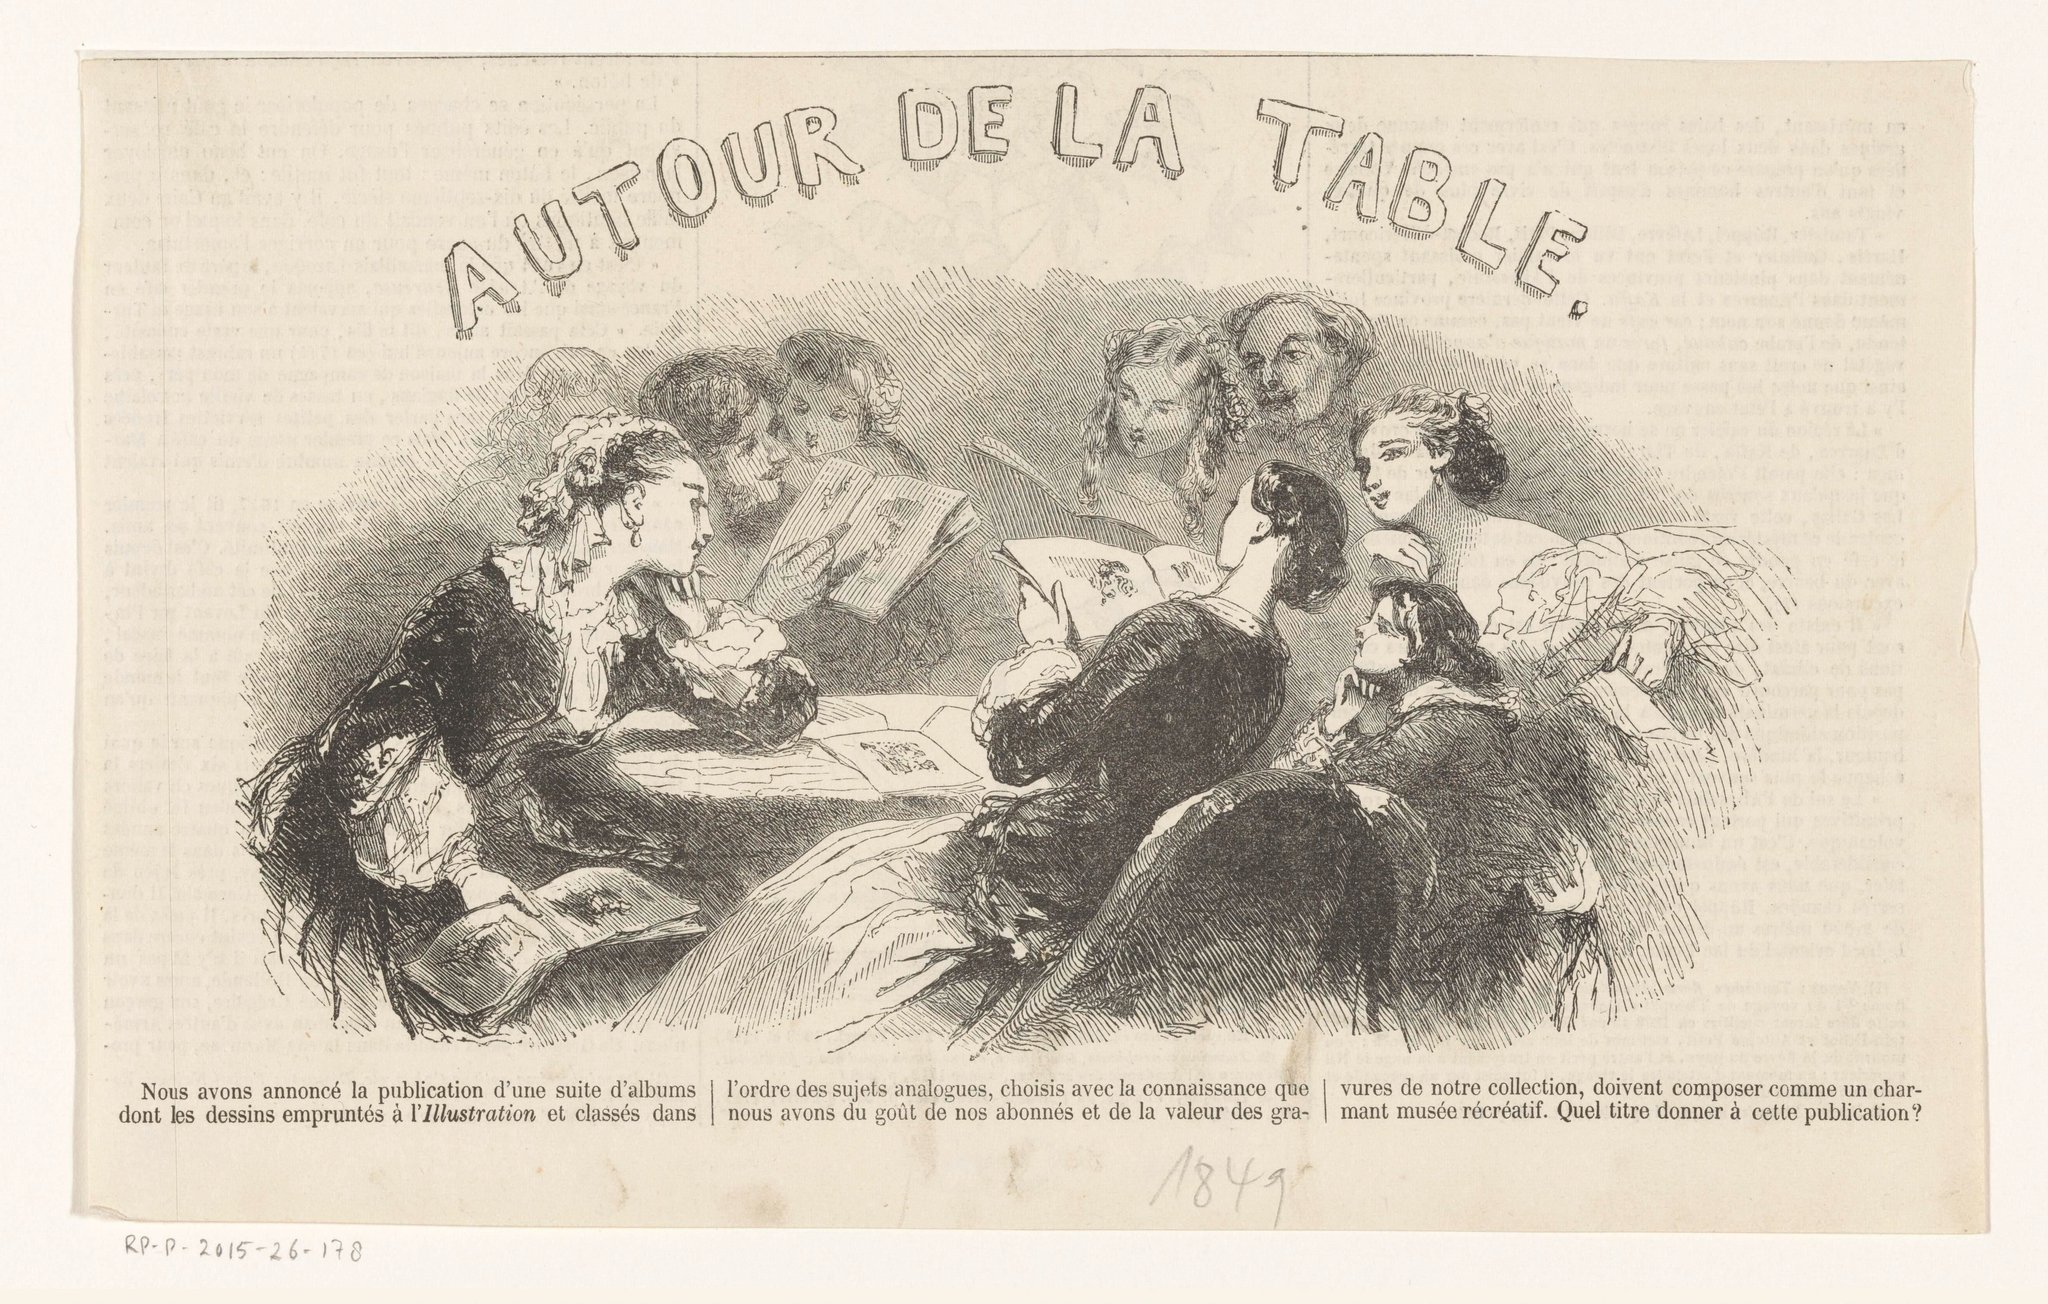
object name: book illustration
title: Autour de la table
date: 1849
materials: paper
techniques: letterpress printing, engraving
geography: paris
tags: book in which illustrations are essential - mm - book open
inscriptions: collector's mark: Lugt 4779, collector's mark: Lugt 4780, collector's mark: Lugt 2228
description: Prent uit: L'illustration. Dl. 14. Parijs: A. le Chevalier et Cie, 1849, p. 157. De prent is een aankondiging voor een album met prenten van Theodore Maurisset: Autour de la table, album des rébus. Parijs: Paulin en Le Chevalier, 1849.